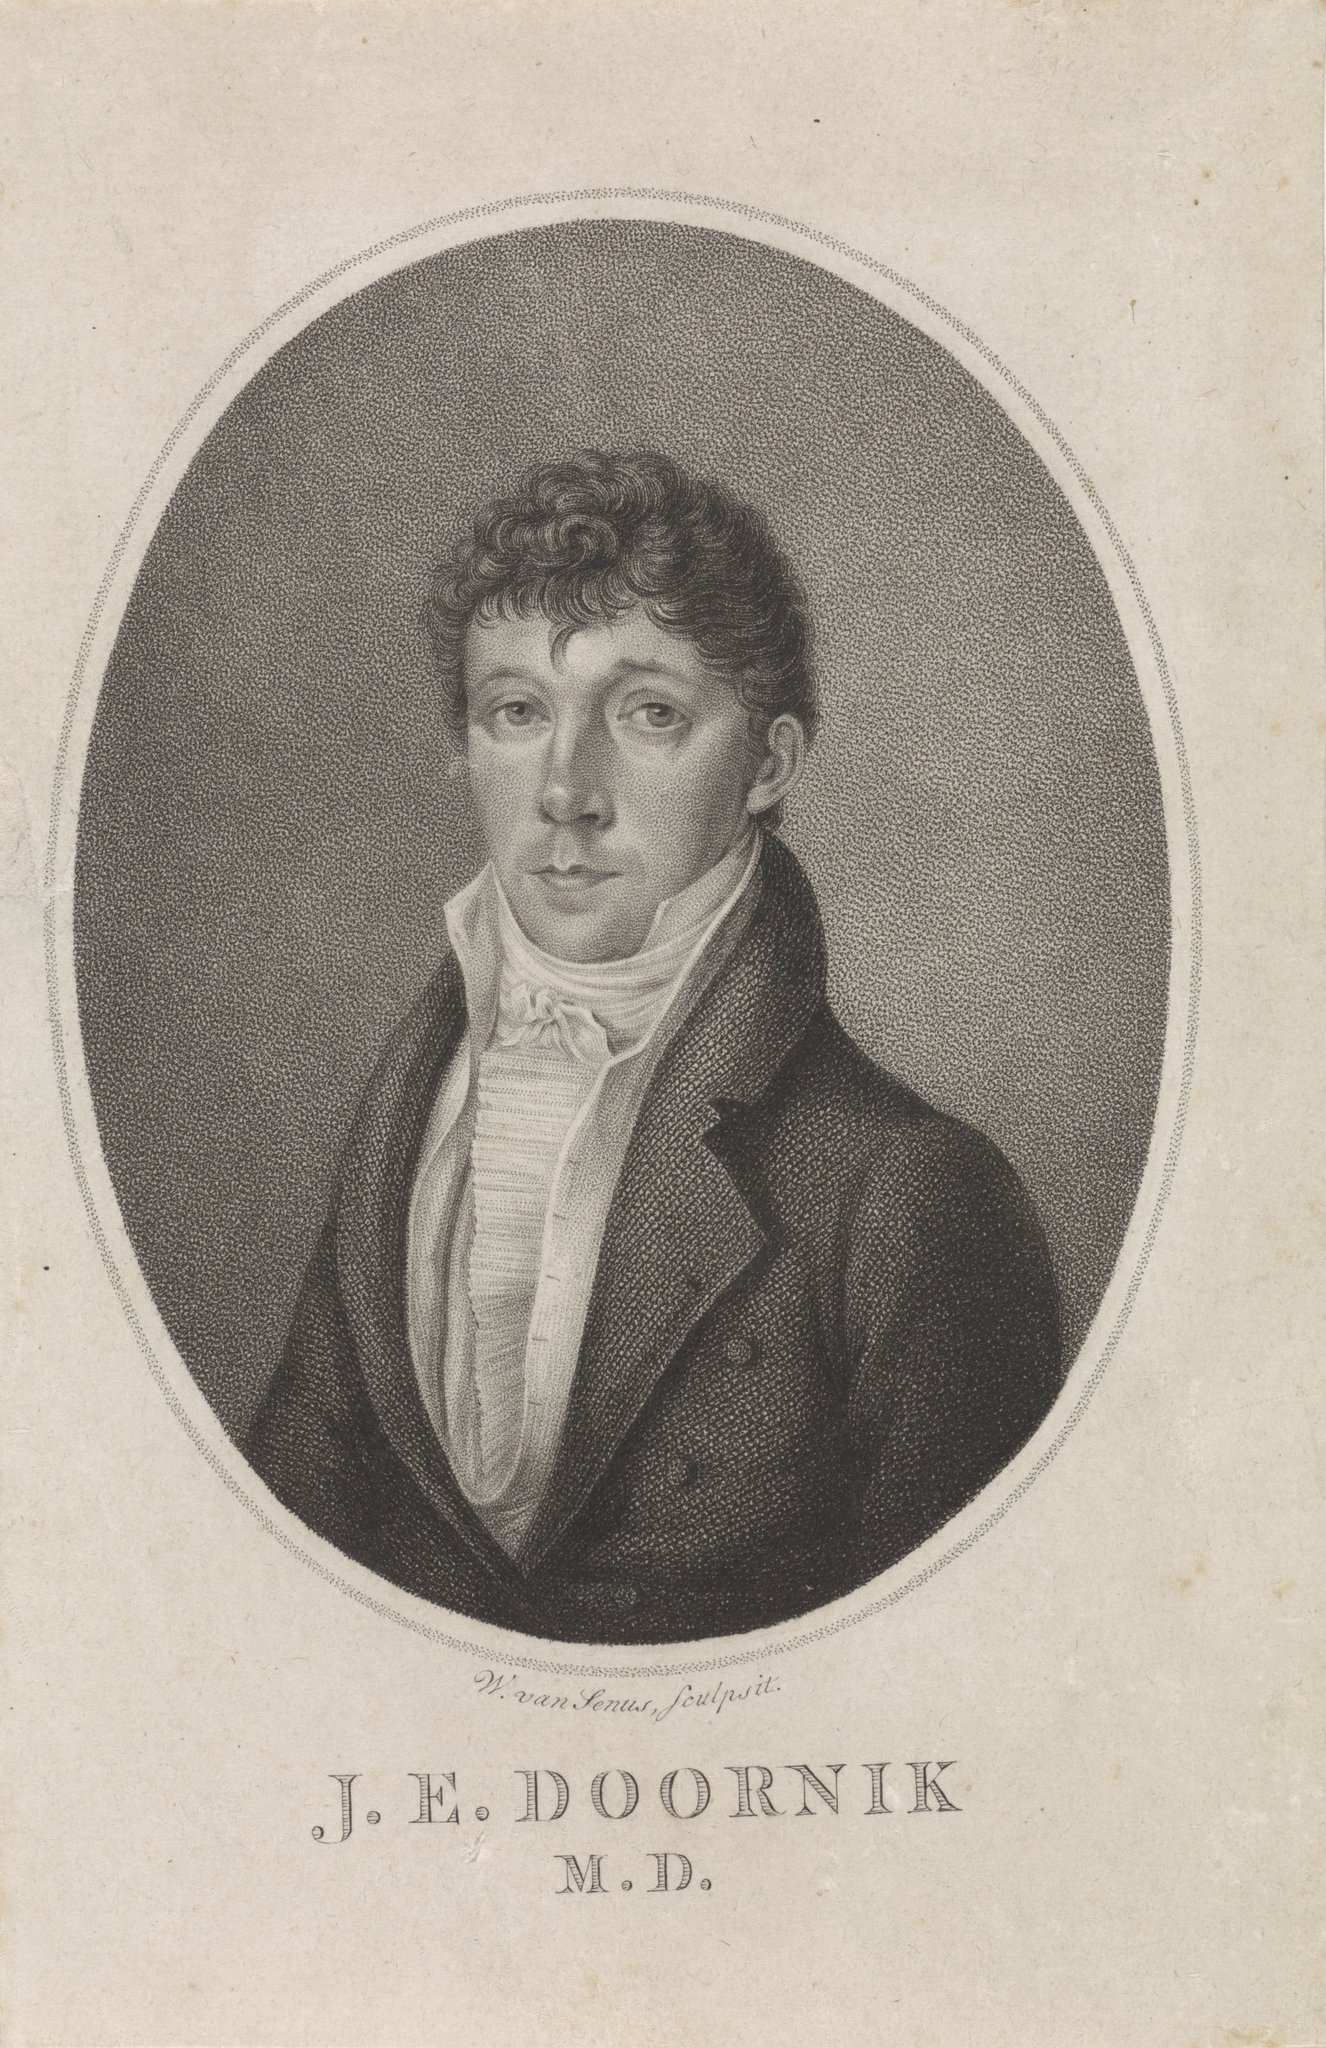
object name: print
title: Portret van Jacob Elisa Doornik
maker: willem van senus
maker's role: painter, print maker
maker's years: 1773-1851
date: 1797-1851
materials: paper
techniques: engraving, etching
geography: netherlands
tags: leiden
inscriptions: collector's mark: Lugt 2228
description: Portret van Jacob Elisa Doornik, doctor in de medicijnen.